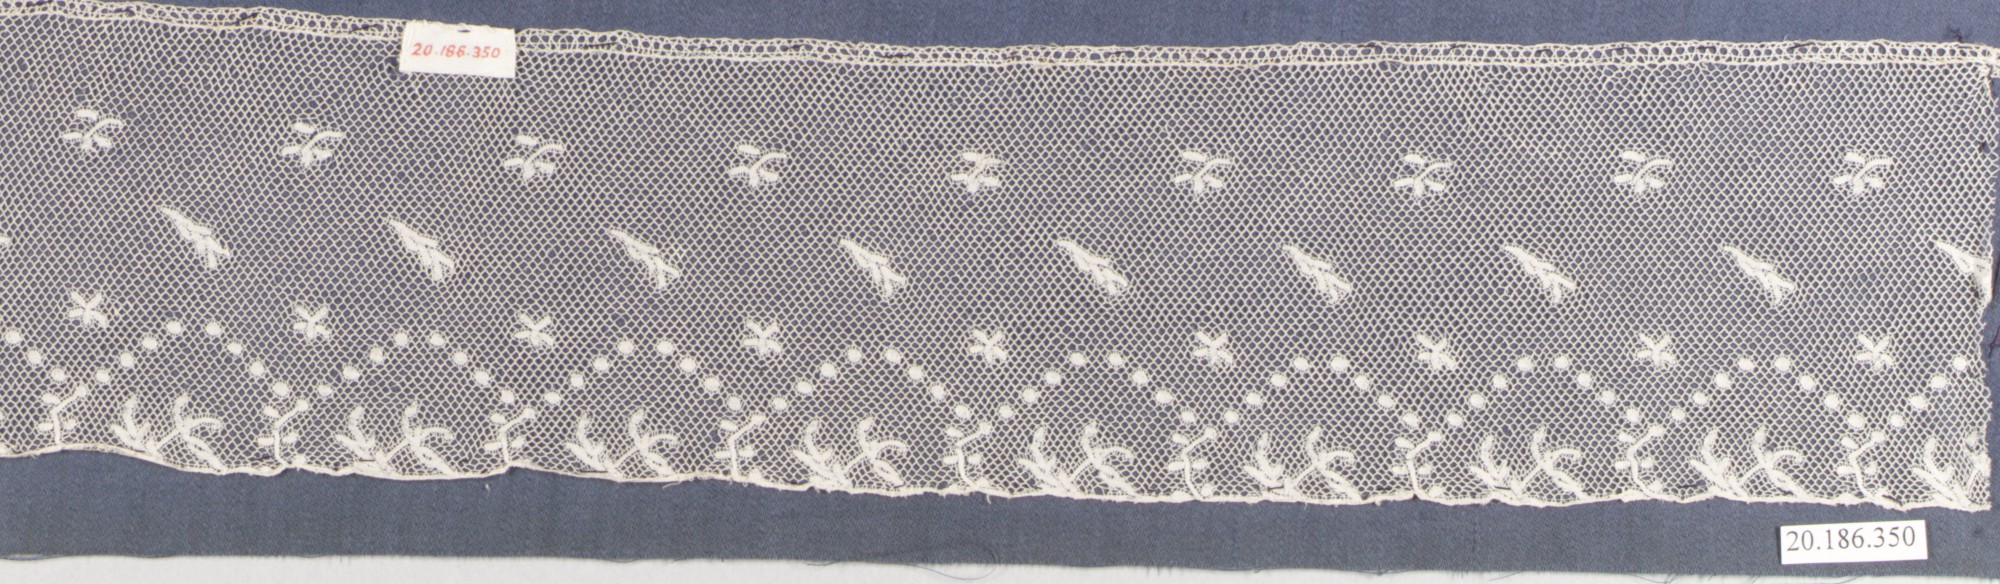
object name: edging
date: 1801-1833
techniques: lace